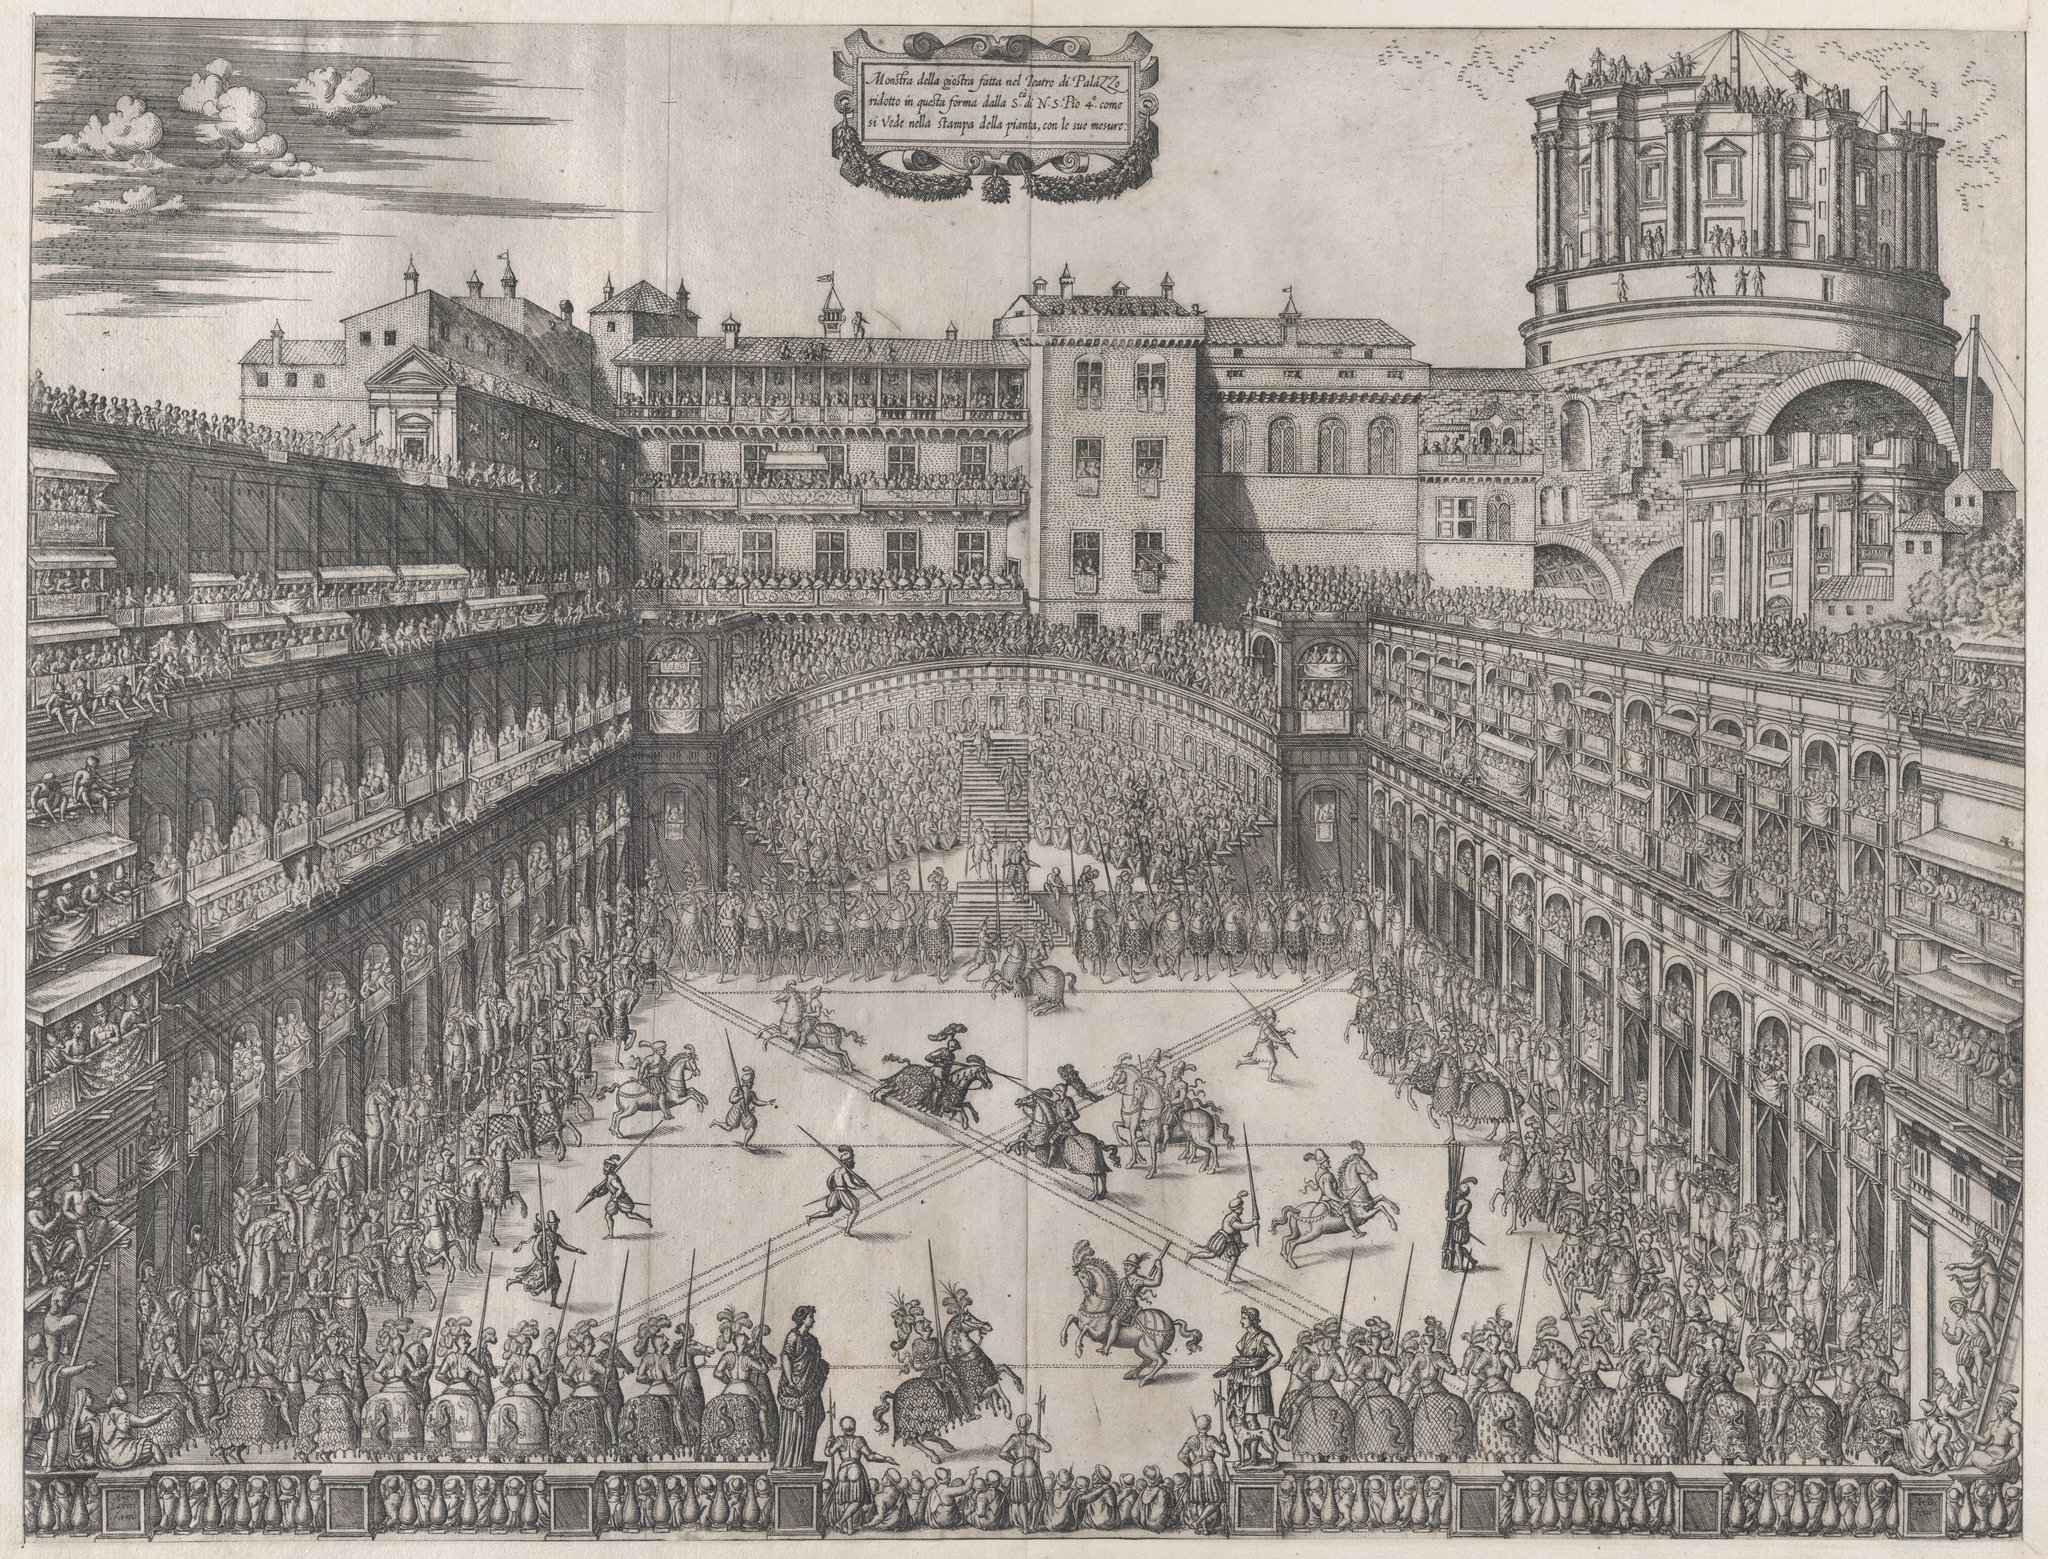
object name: print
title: Vatican Tournament, from "Speculum Romanae Magnificentiae"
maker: master hcb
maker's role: artist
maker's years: 1565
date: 1565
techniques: etching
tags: buildings,playing,horses,crowd,rome